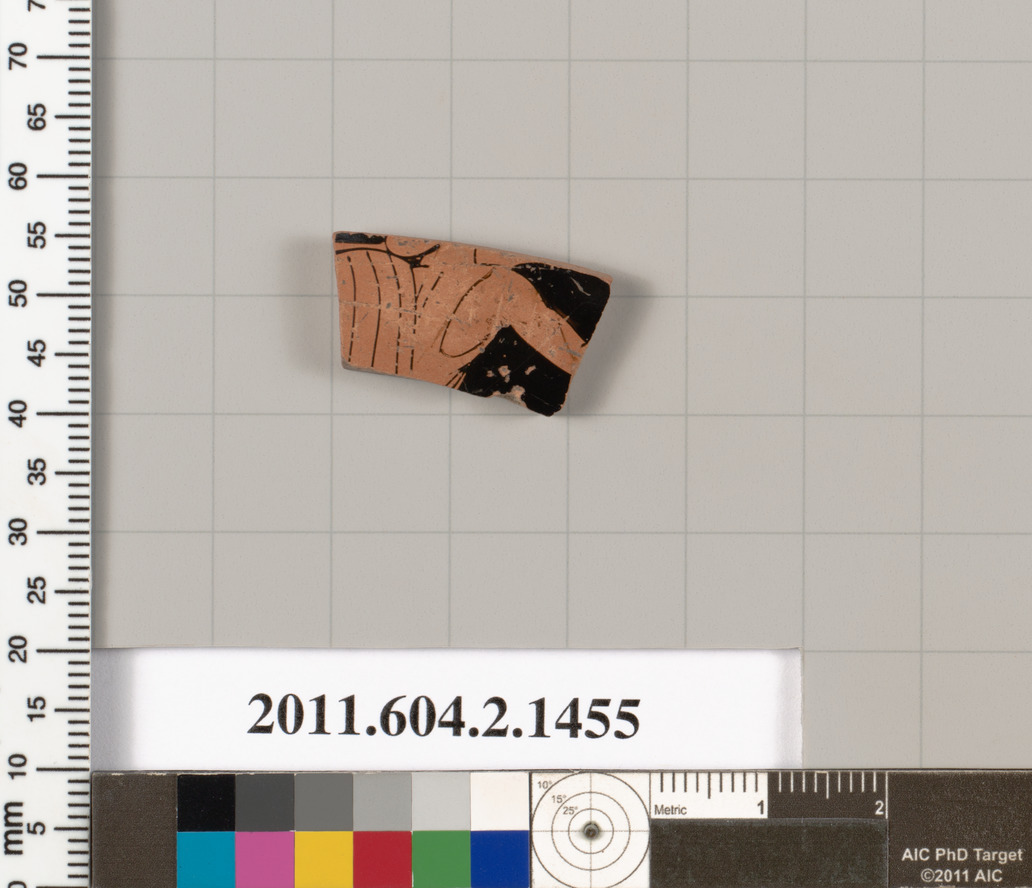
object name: skyphos fragment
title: Terracotta fragment of a skyphos (deep drinking cup)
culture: greek, attic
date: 467-435 BCE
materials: terracotta